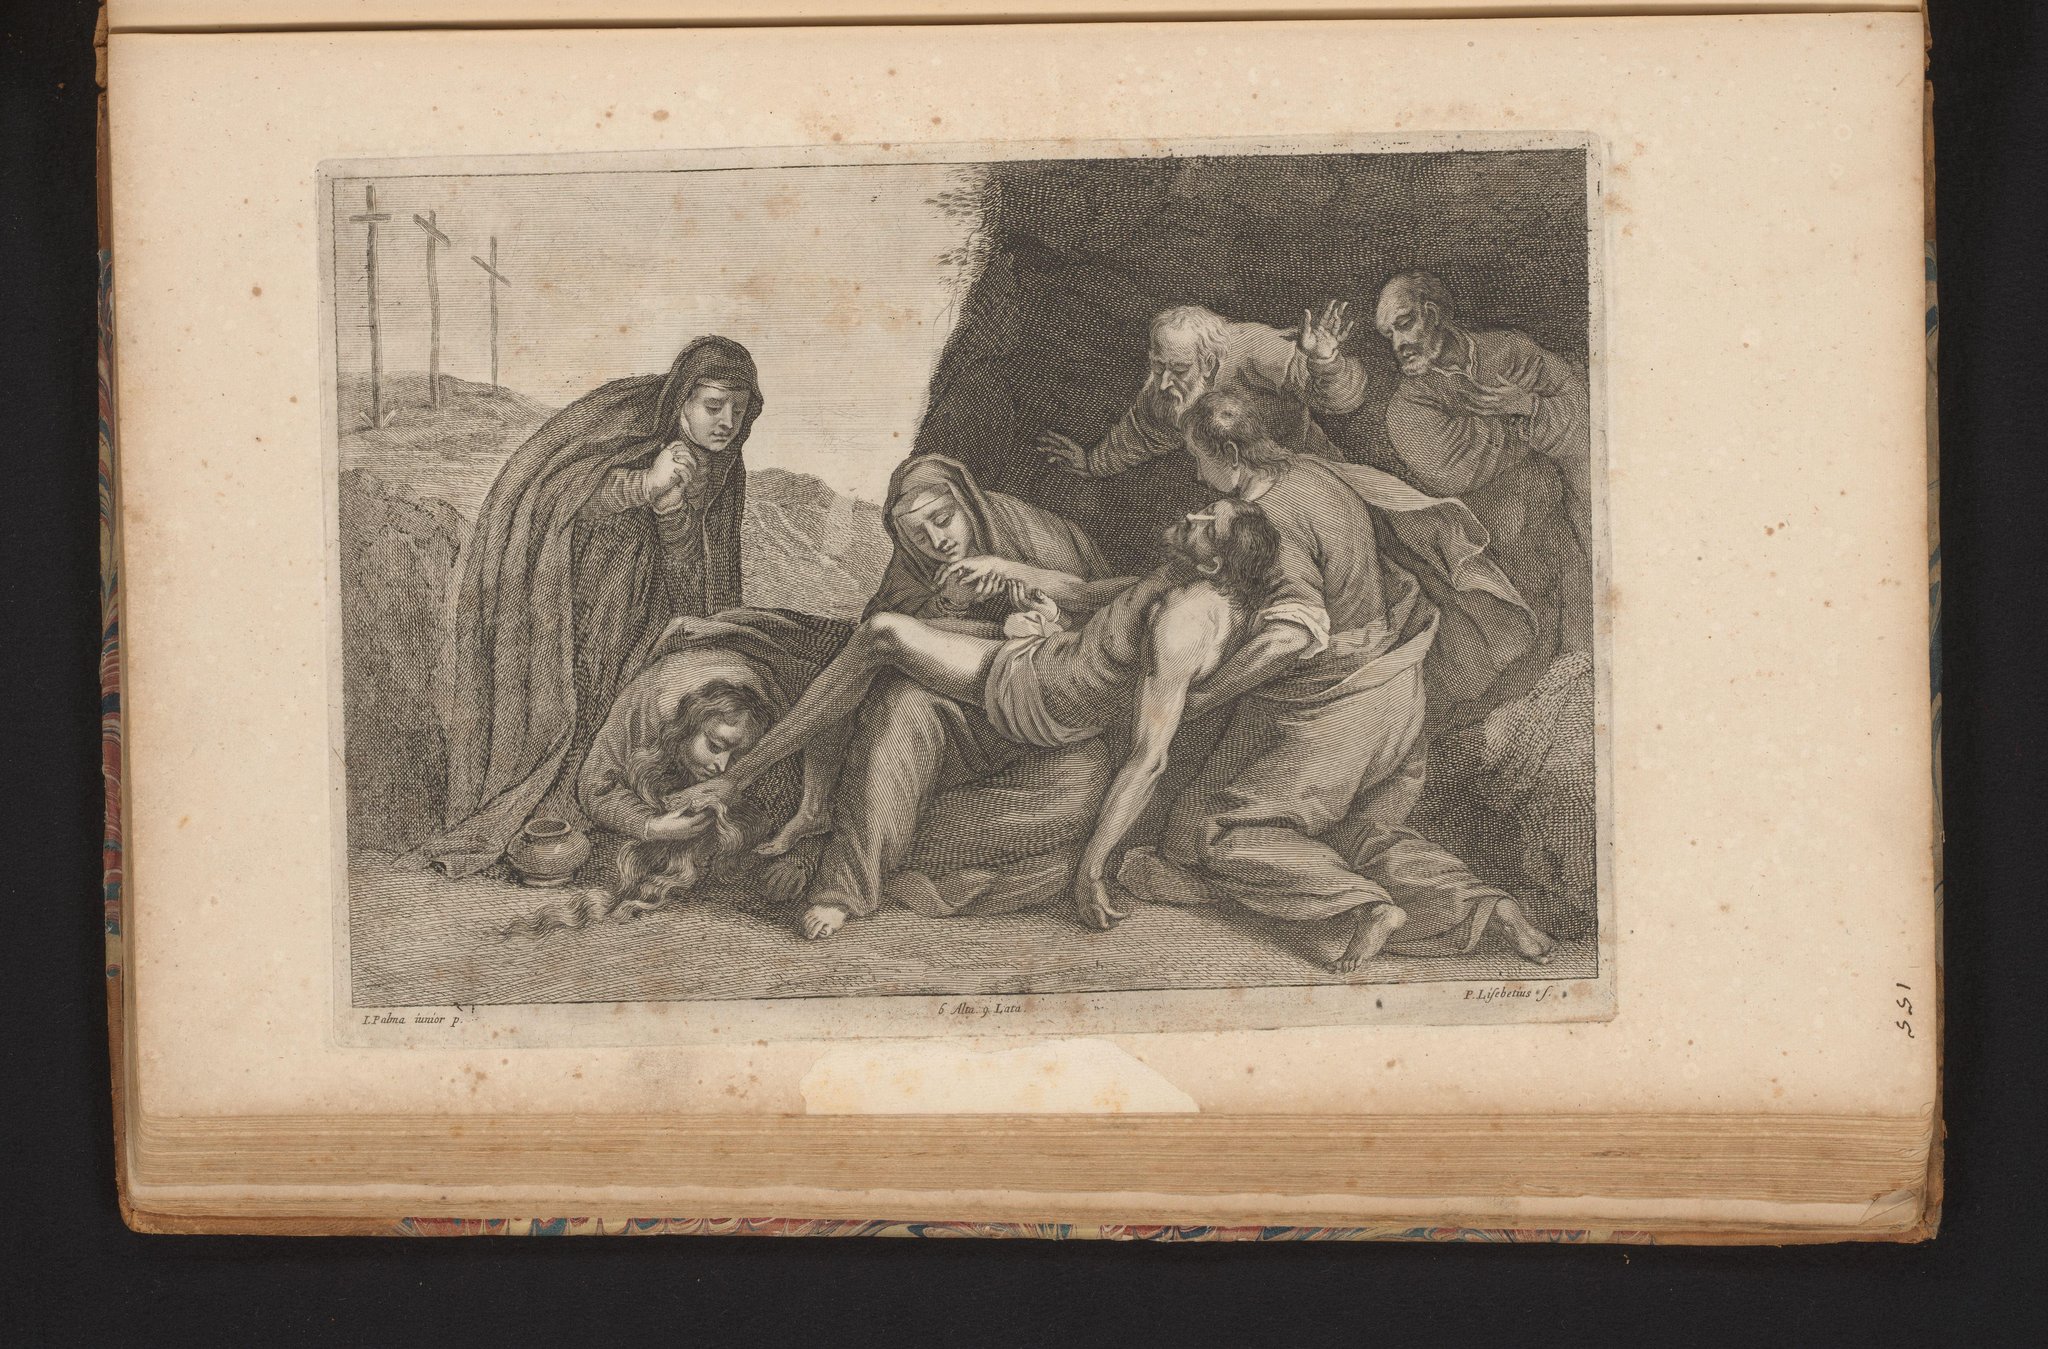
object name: album leaf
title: Bewening van Christus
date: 1660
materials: paper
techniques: engraving, etching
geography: brussels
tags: christ's body supported by mary, others present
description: De prent is vervaardigd naar het schilderij uit het atelier van Palma dat zich in de collectie van het Kunsthistorisches Museum te Wenen bevindt (inventarisnummer GG_2). David Teniers heeft waarschijnlijk van alle schilderijen uit de collectie van Leopold Willem van Oostenrijk een olieverfstudie op doek of paneel vervaardigd (zgn. pasticcio), die als voorbeeld voor de prentmakers diende. Het is niet altijd duidelijk of de pasticci door hem zijn gemaakt of door zijn atelier. Niet alle pasticci zijn overgeleverd.